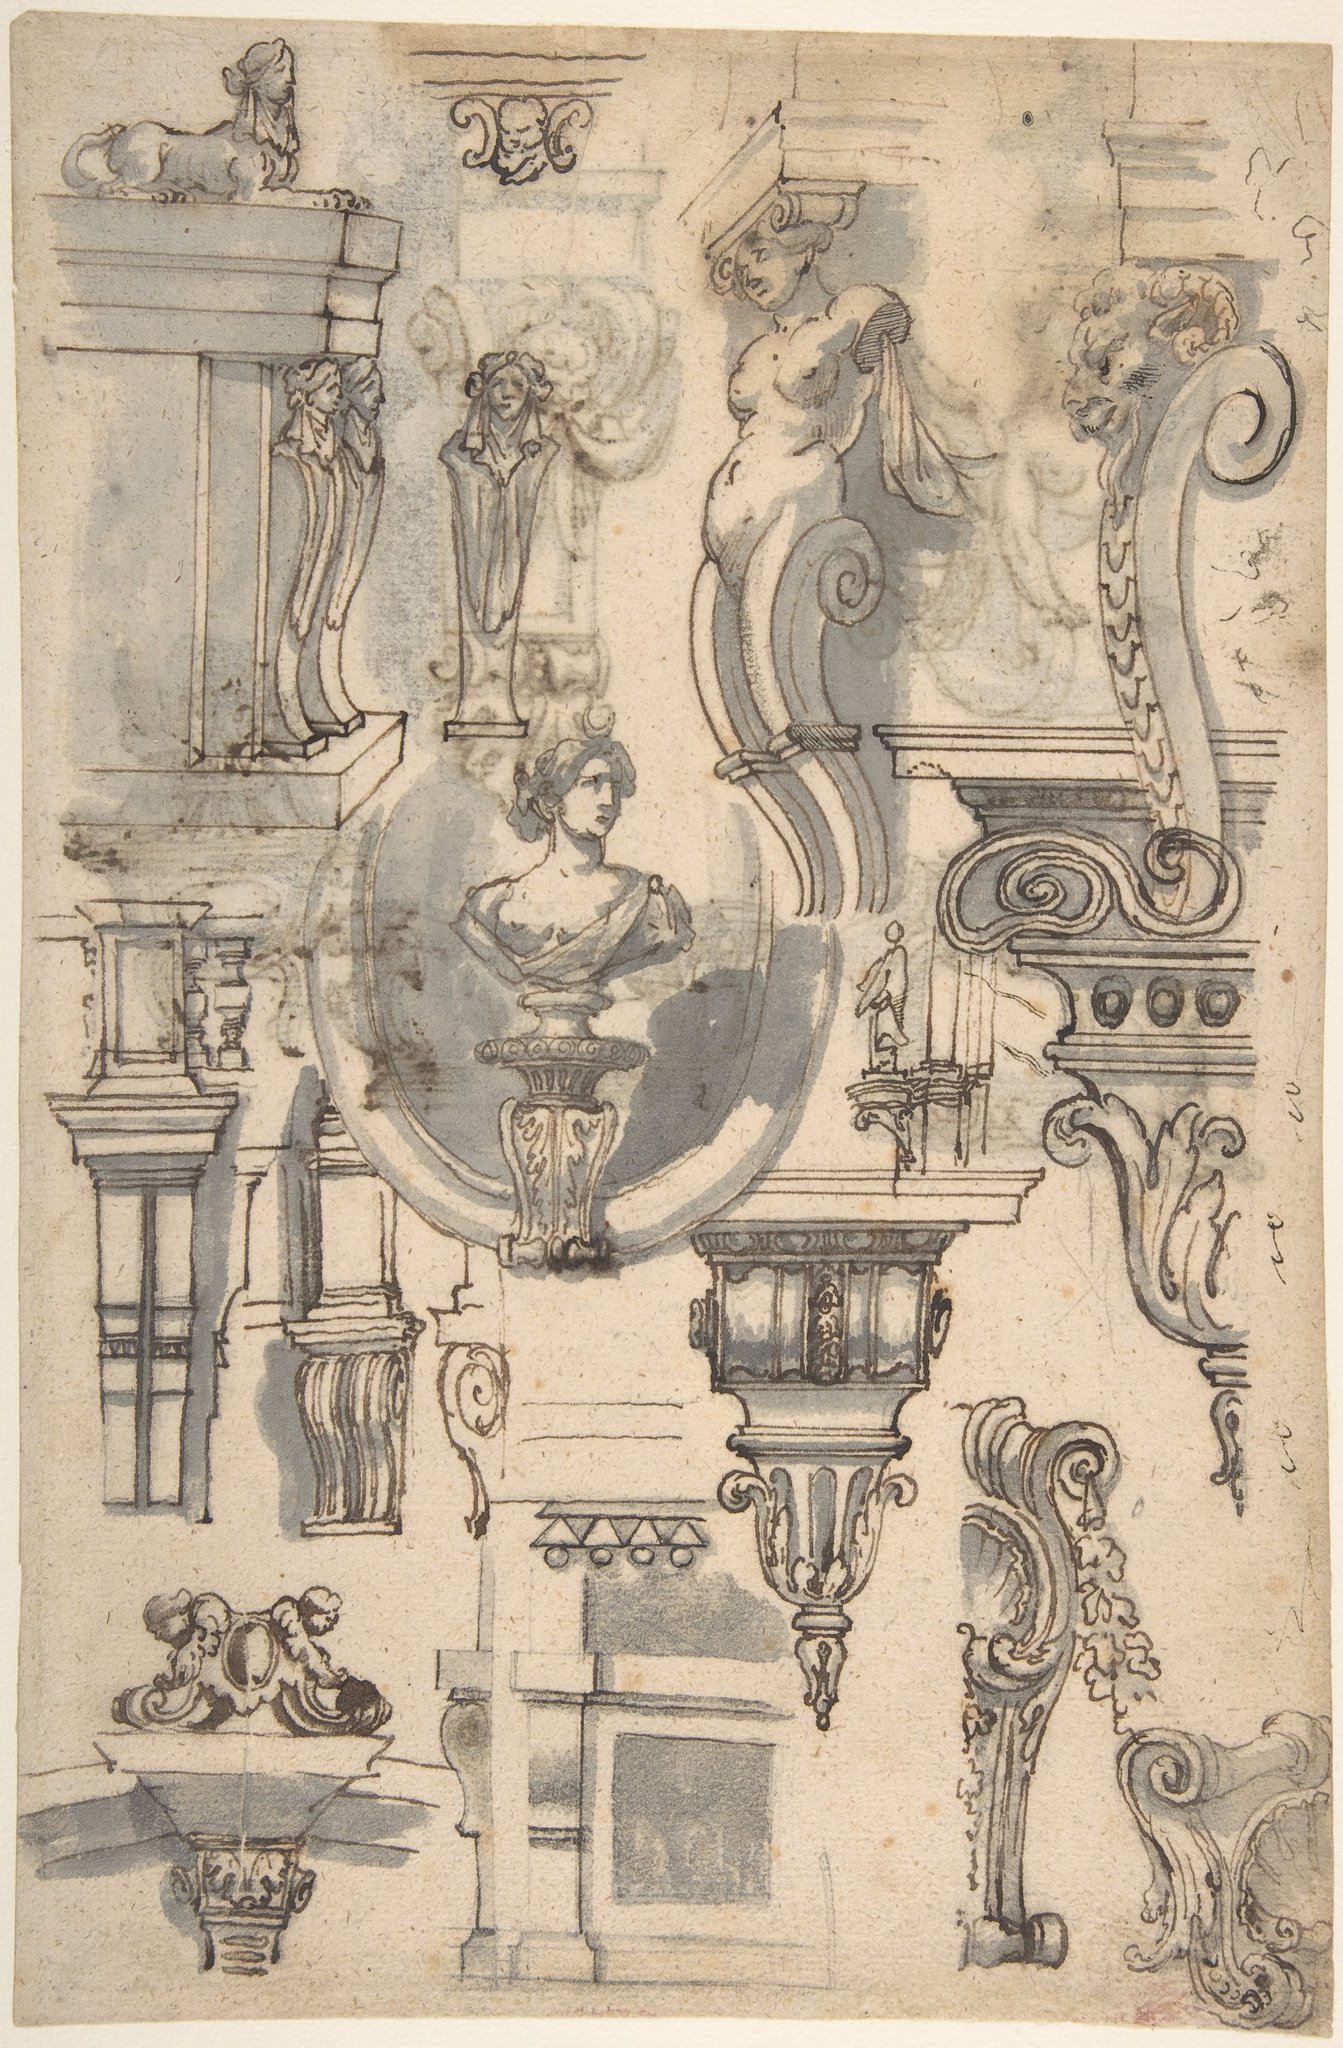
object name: ornament architecture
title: Brackets, Caryatids and other Architectural Details (recto and verso)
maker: gilles-marie oppenord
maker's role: artist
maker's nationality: french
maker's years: 1672-1742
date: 1690-1710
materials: graphite, ink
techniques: brush, pen, drawing, wash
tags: architecture